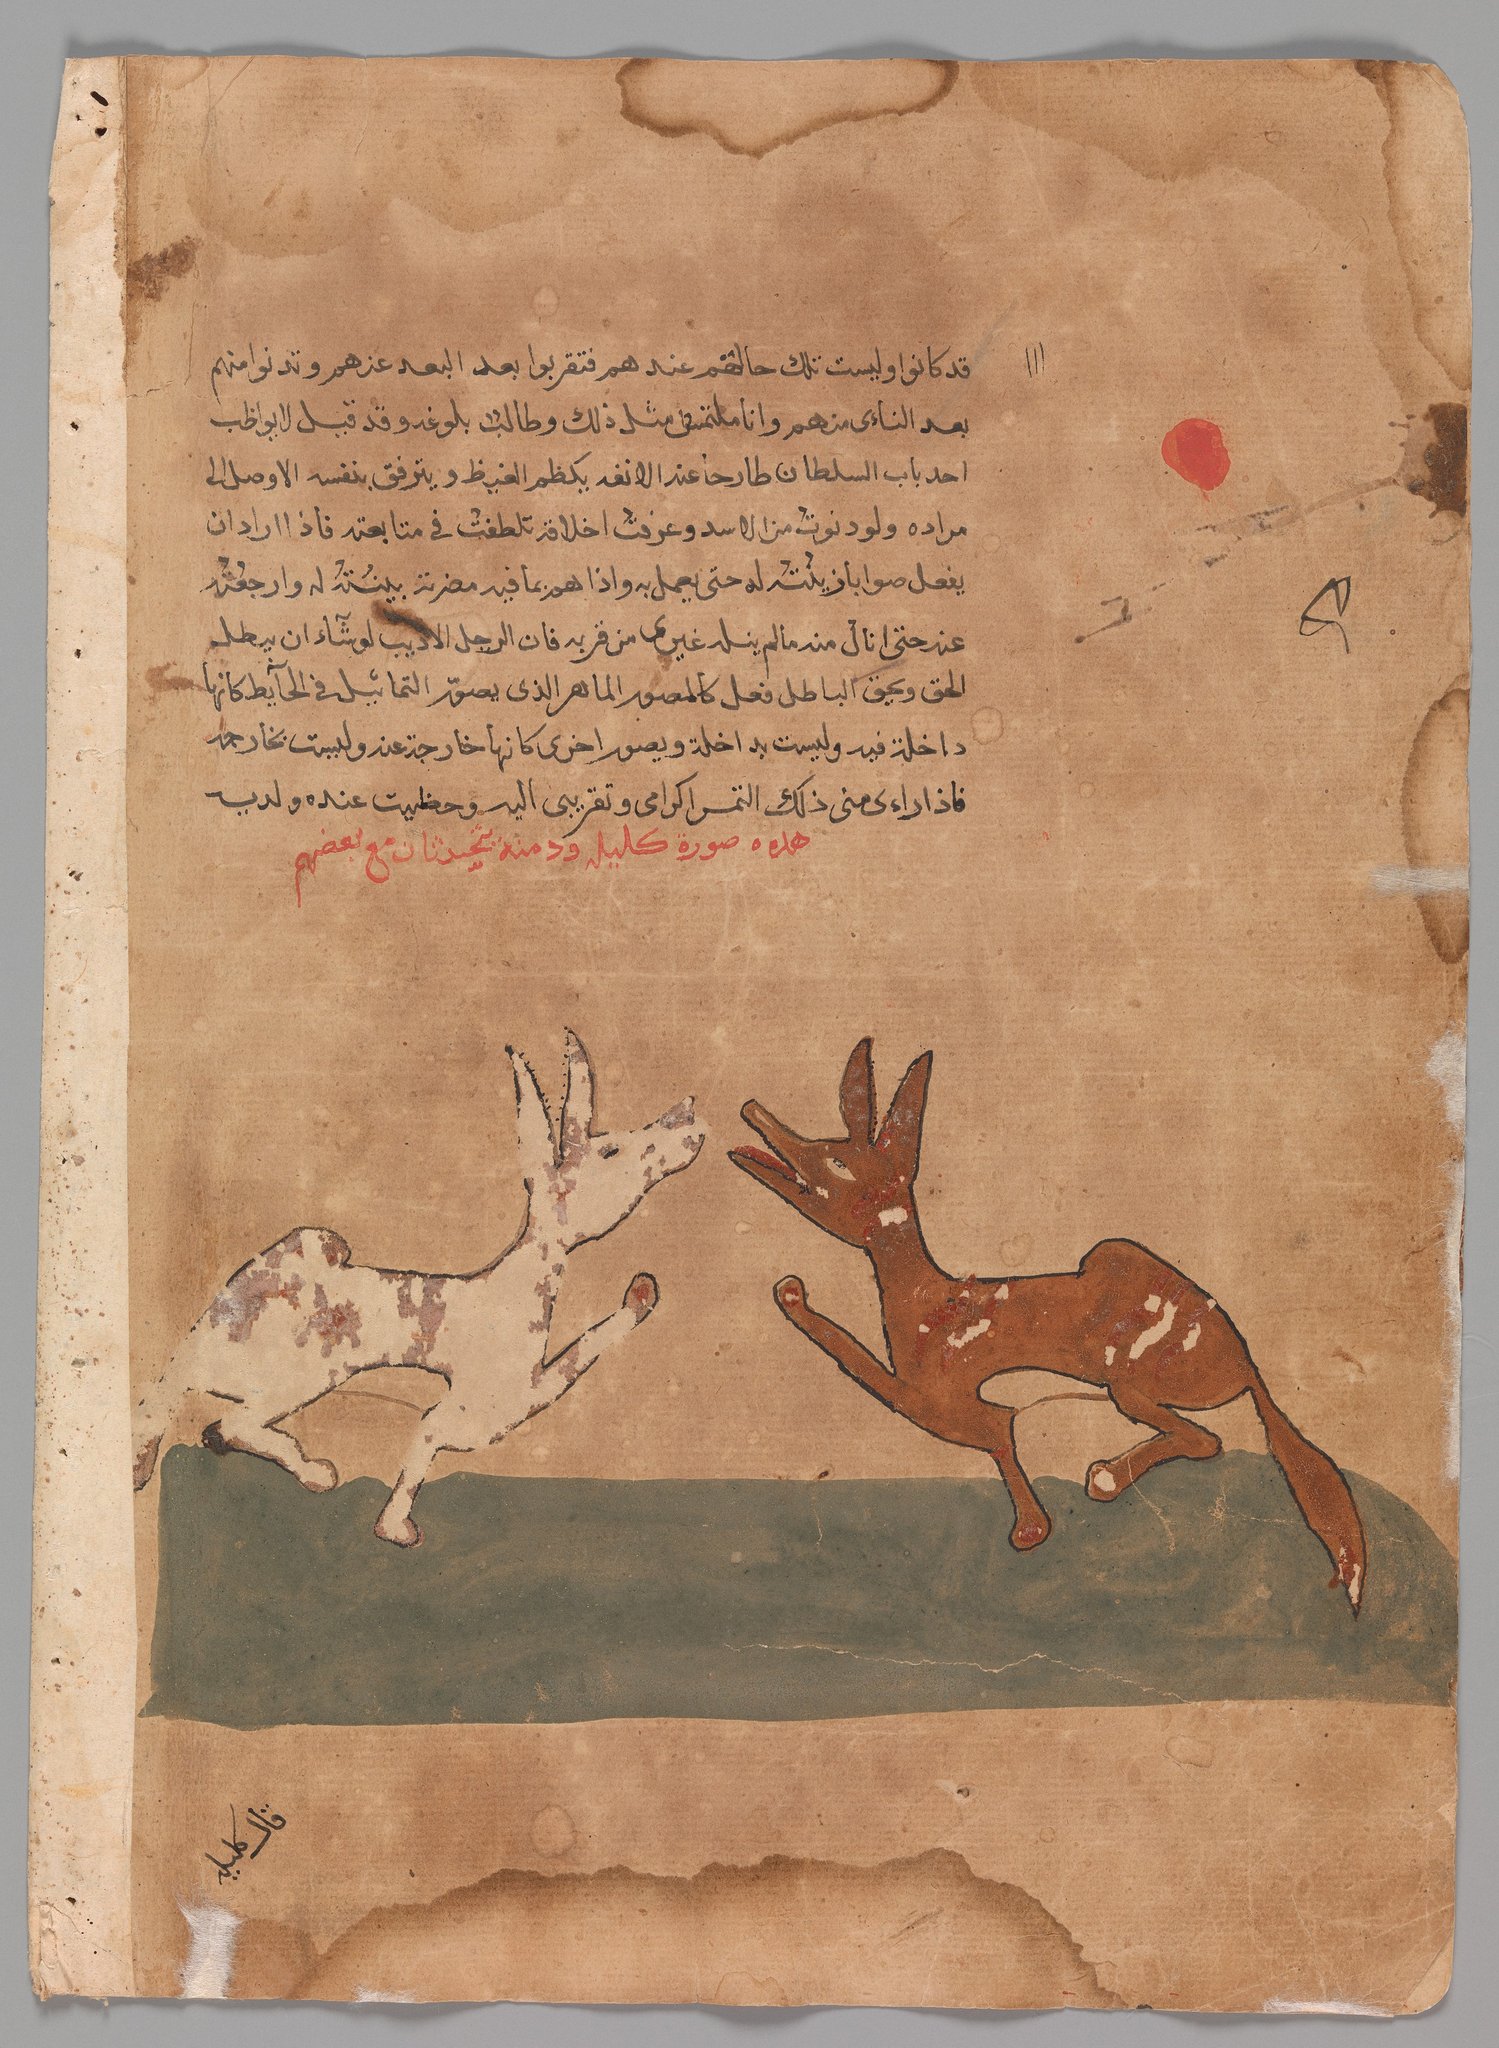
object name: folio from an illustrated manuscript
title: "Kalila and Dimna Discussing Dimna's Plans to Become a Confidante of the Lion", Folio from a Kalila wa Dimna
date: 1526-1550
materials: ink, paper, watercolor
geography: india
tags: animals